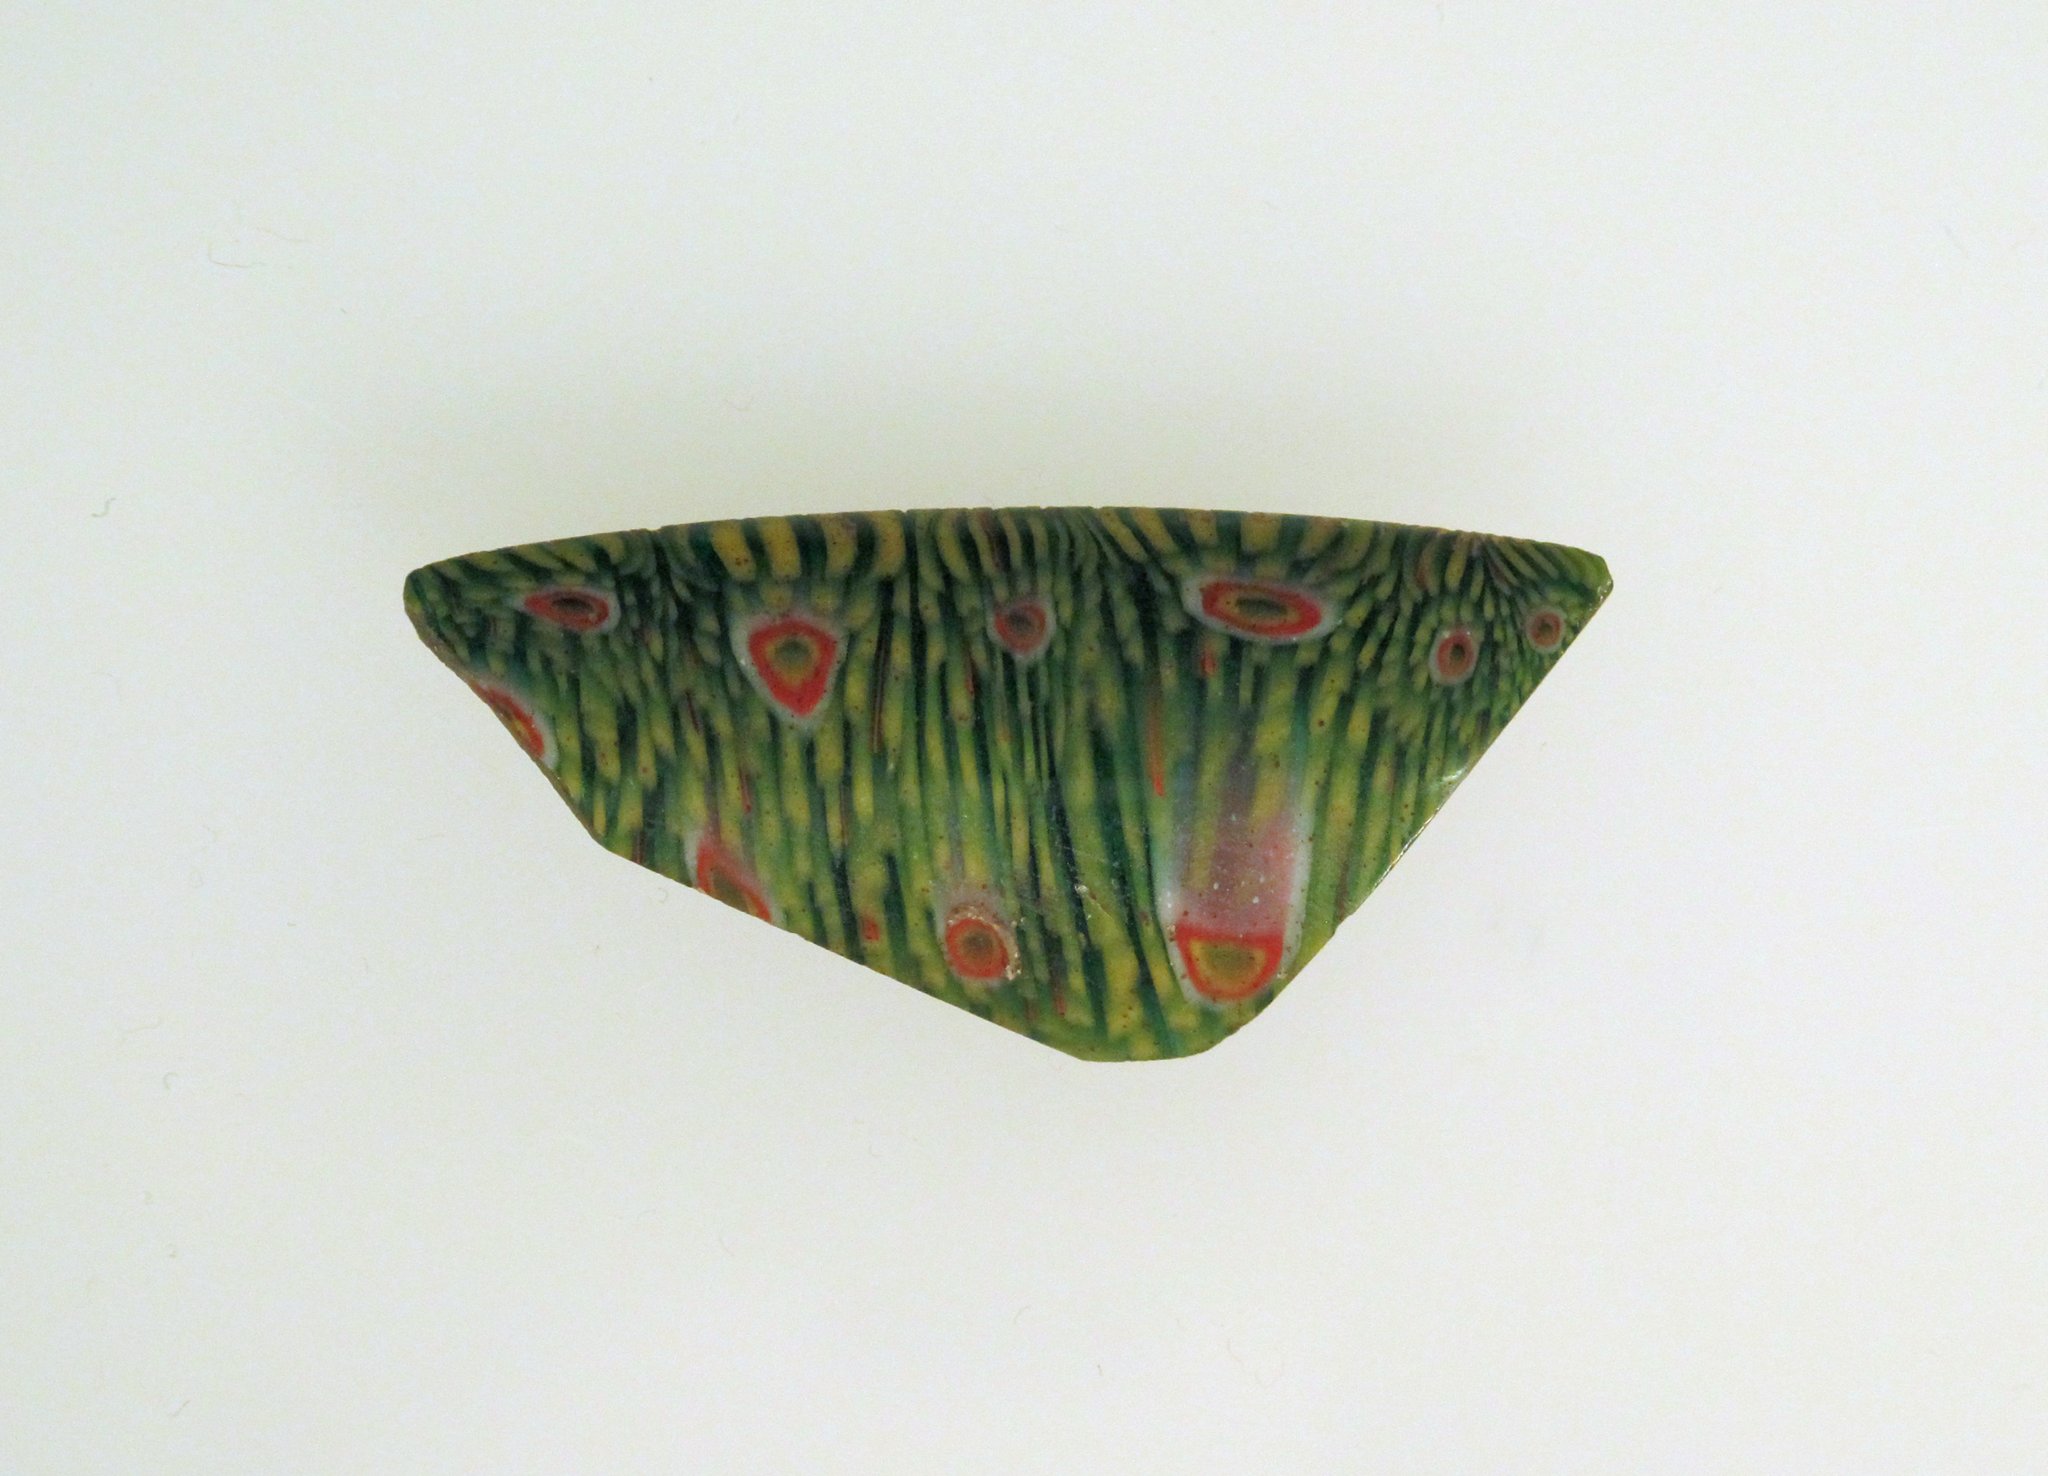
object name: fragment, mosaic bowl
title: Glass mosaic bowl fragment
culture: roman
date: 34 BCE-33 CE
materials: glass